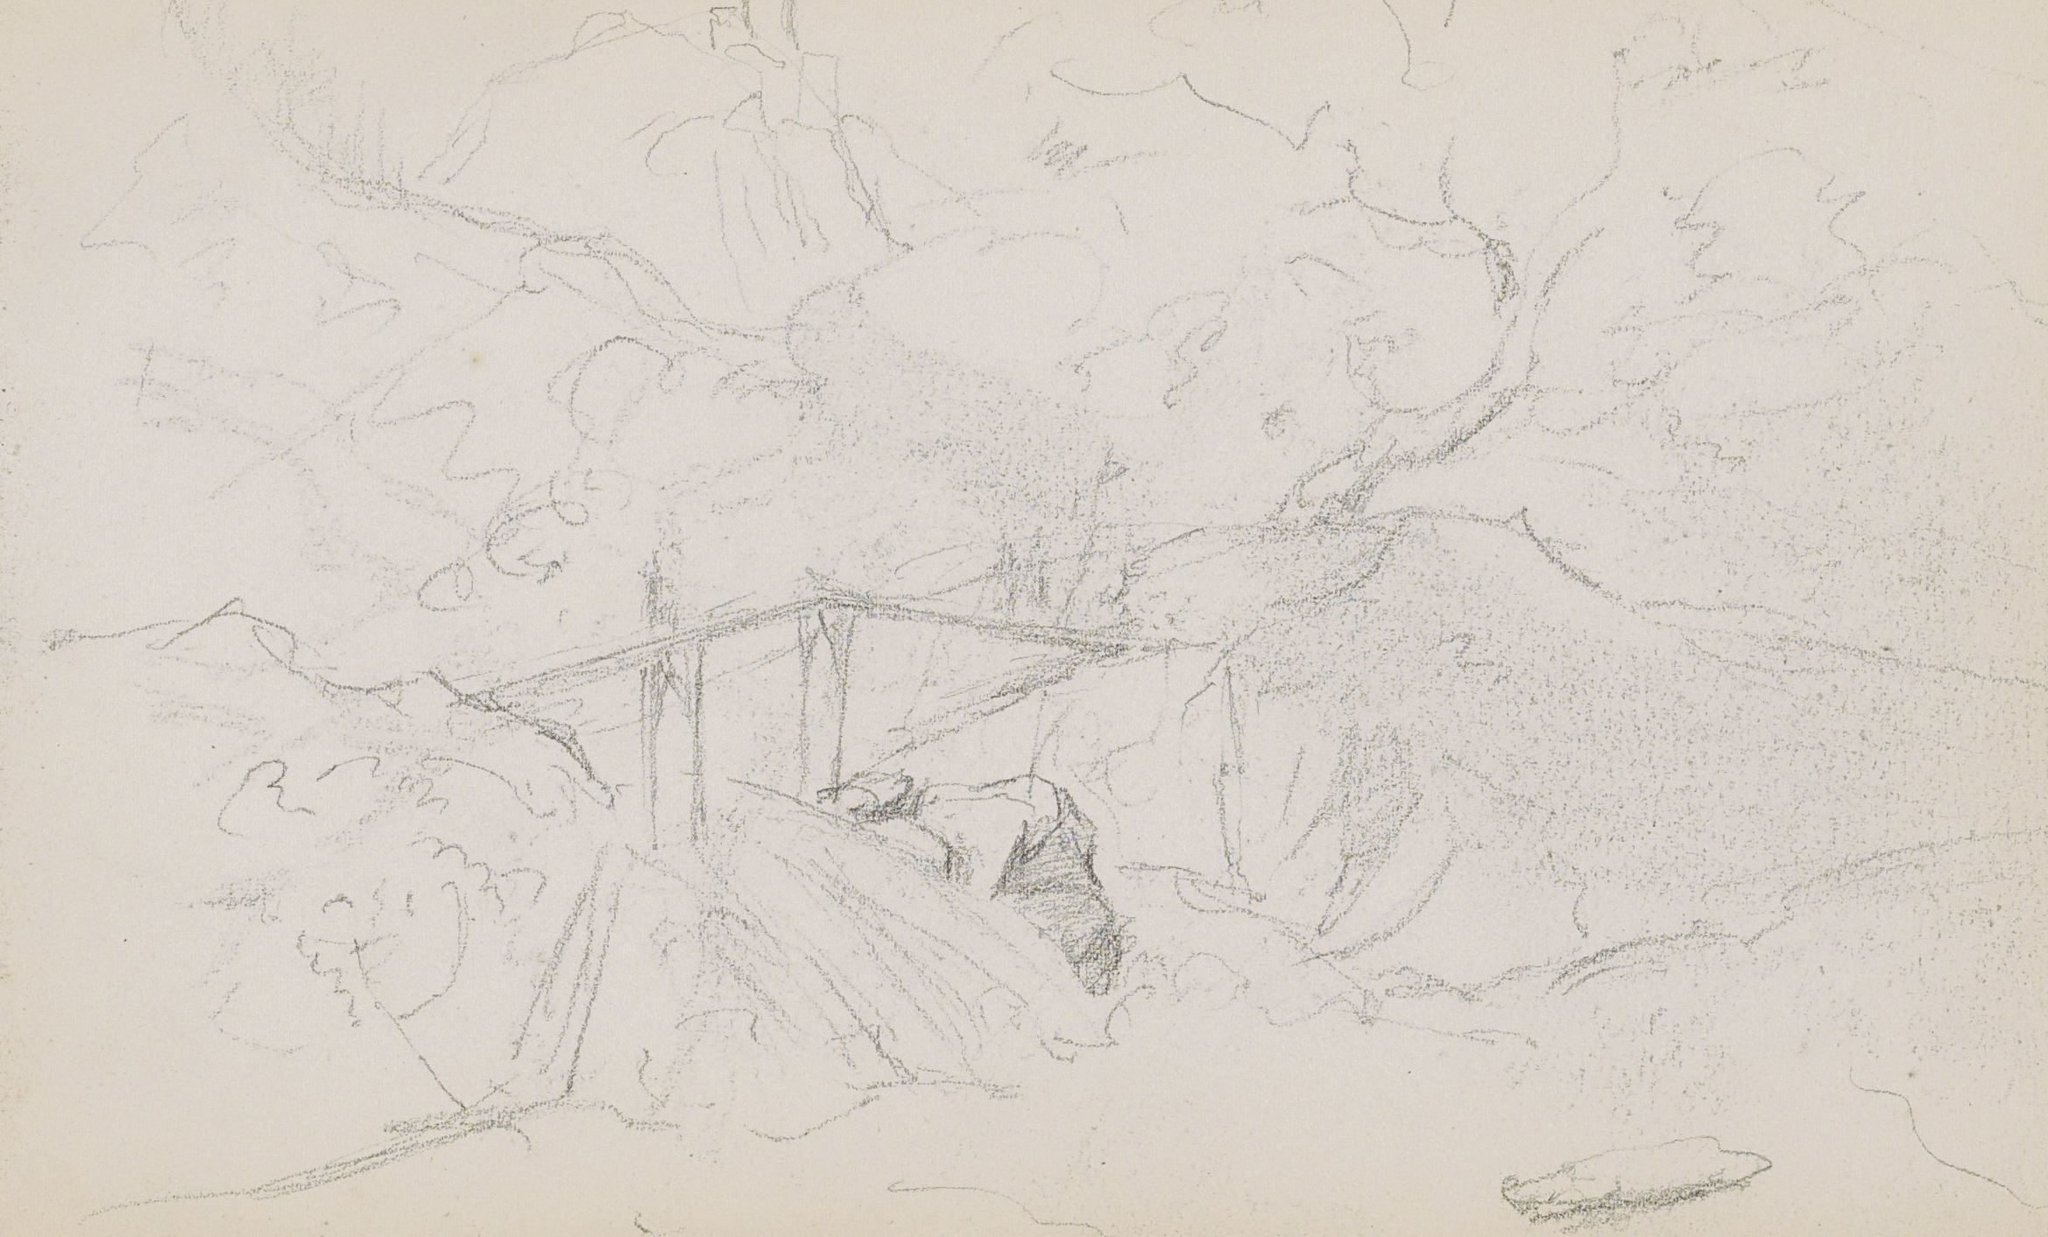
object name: sketchbook leaf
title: Brug in een berglandschap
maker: willem cornelis rip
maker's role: draughtsman, painter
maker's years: 1856-1922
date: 1874-1875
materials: paper, pencil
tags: bridge, mountains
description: Op de achtergrond een toren, mogelijk van een kasteel, op een bergtop. Blad 10 recto uit een schetsboek met 46 bladen.